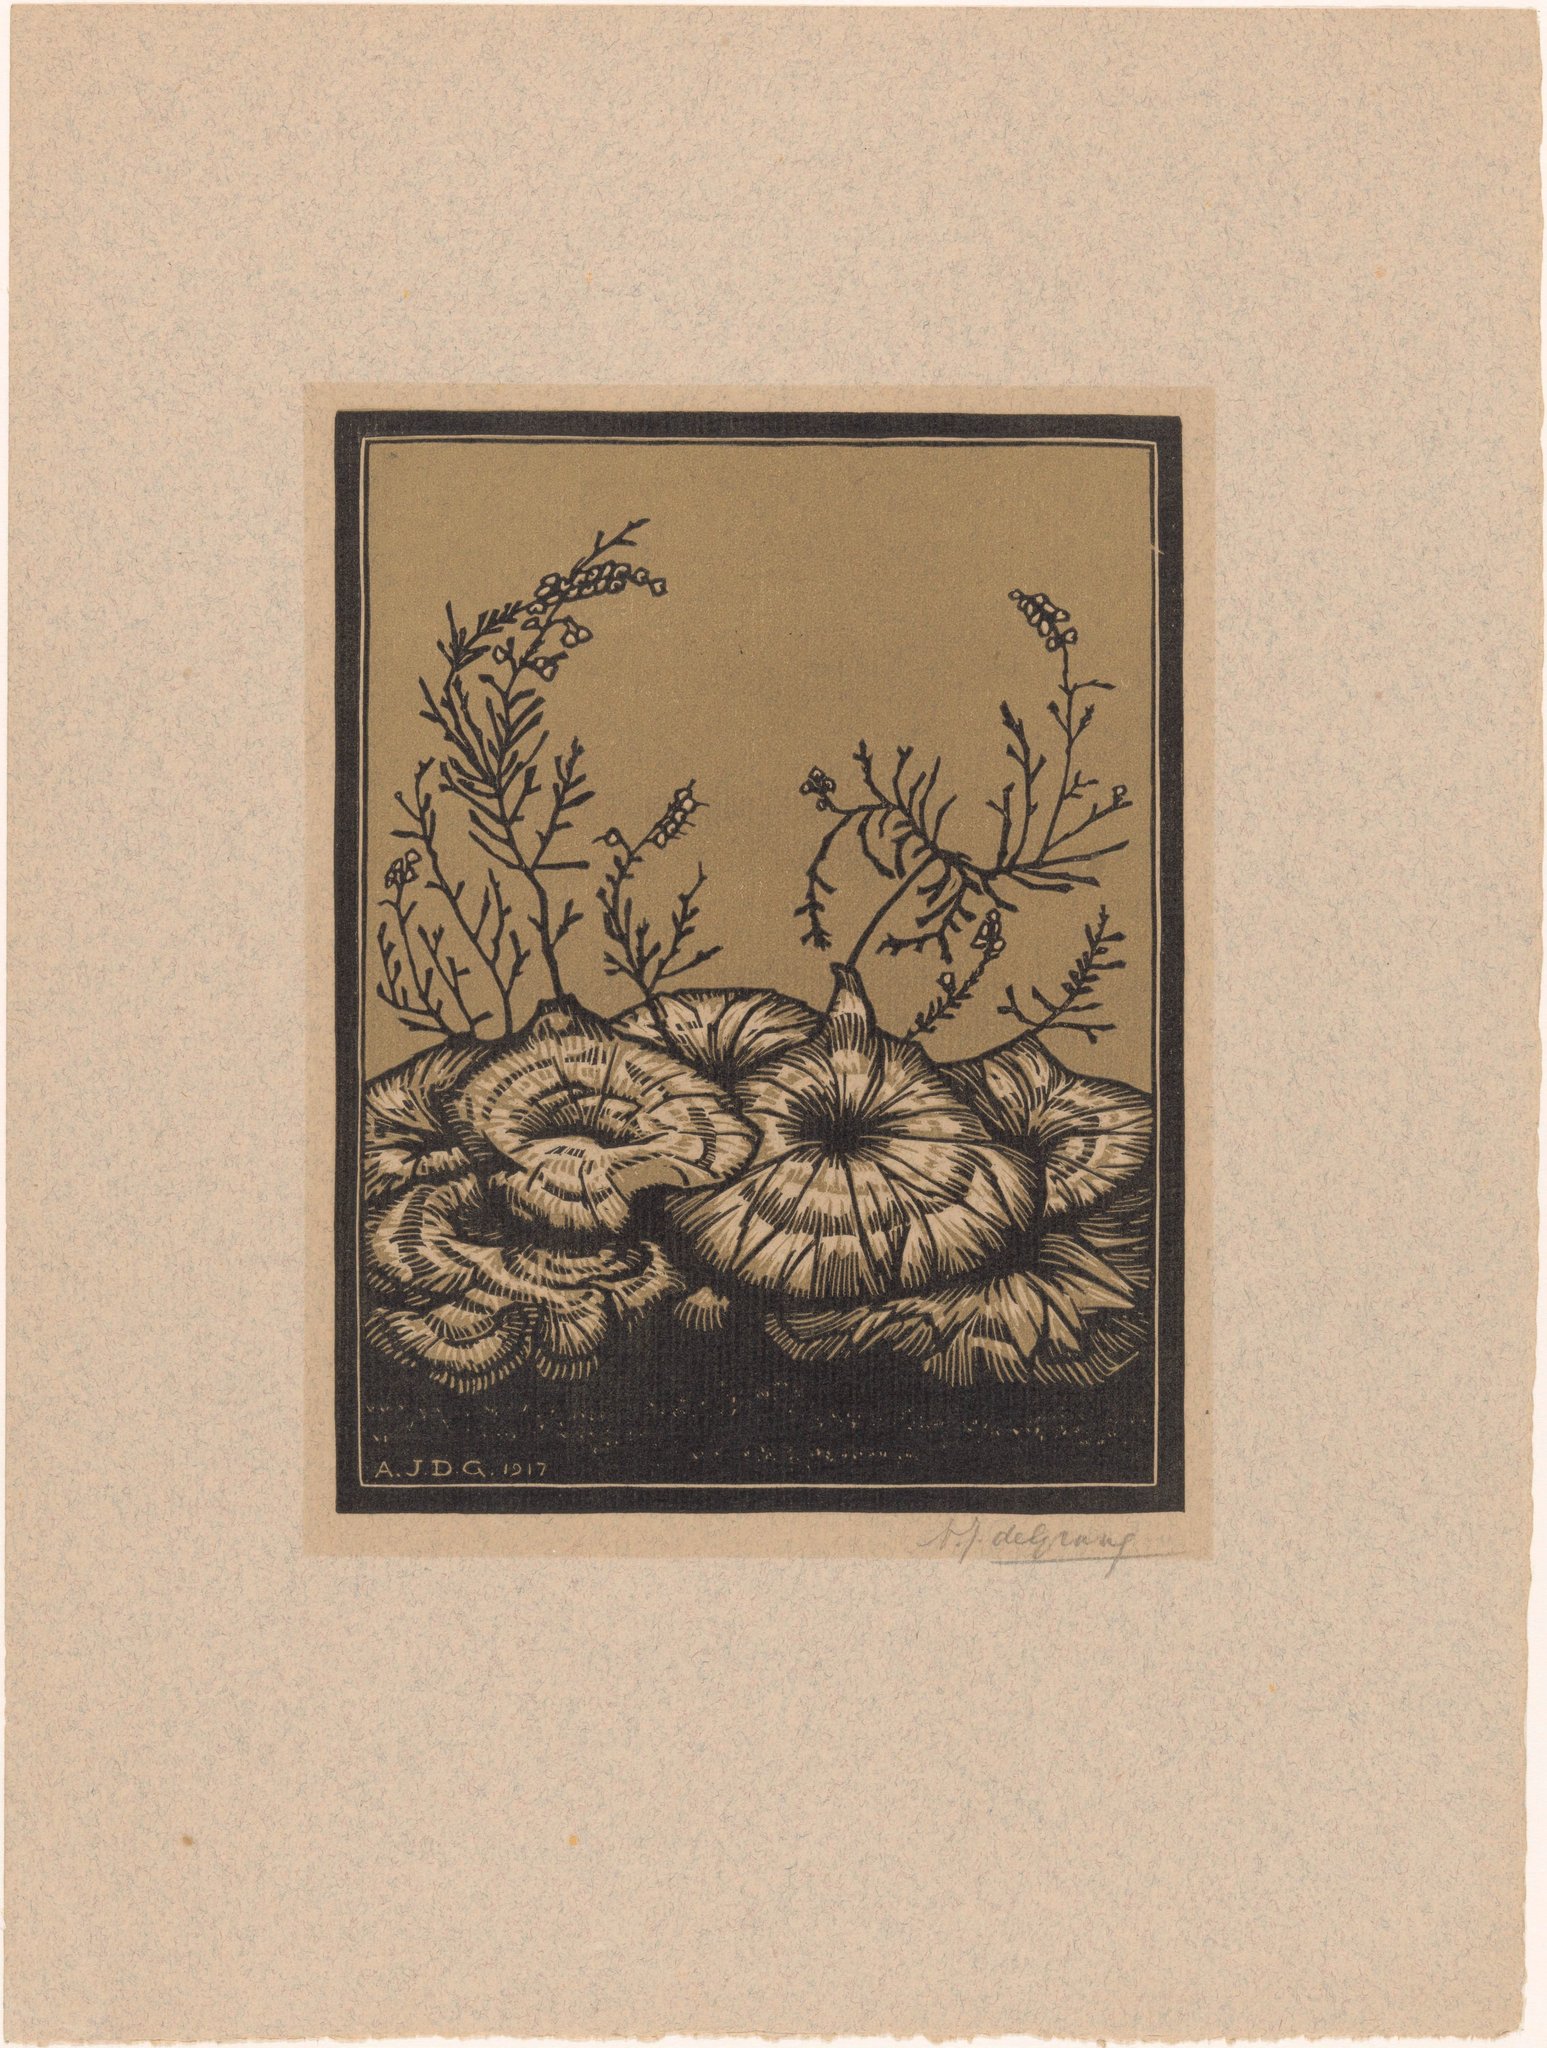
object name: print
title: Bloeiende planten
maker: julie de graag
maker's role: draughtsman, print maker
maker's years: 1877-1924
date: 1917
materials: paper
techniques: woodcut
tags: plants; vegetation (+ flowers, blossom, blossoming)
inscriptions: collector's mark: Lugt 2228